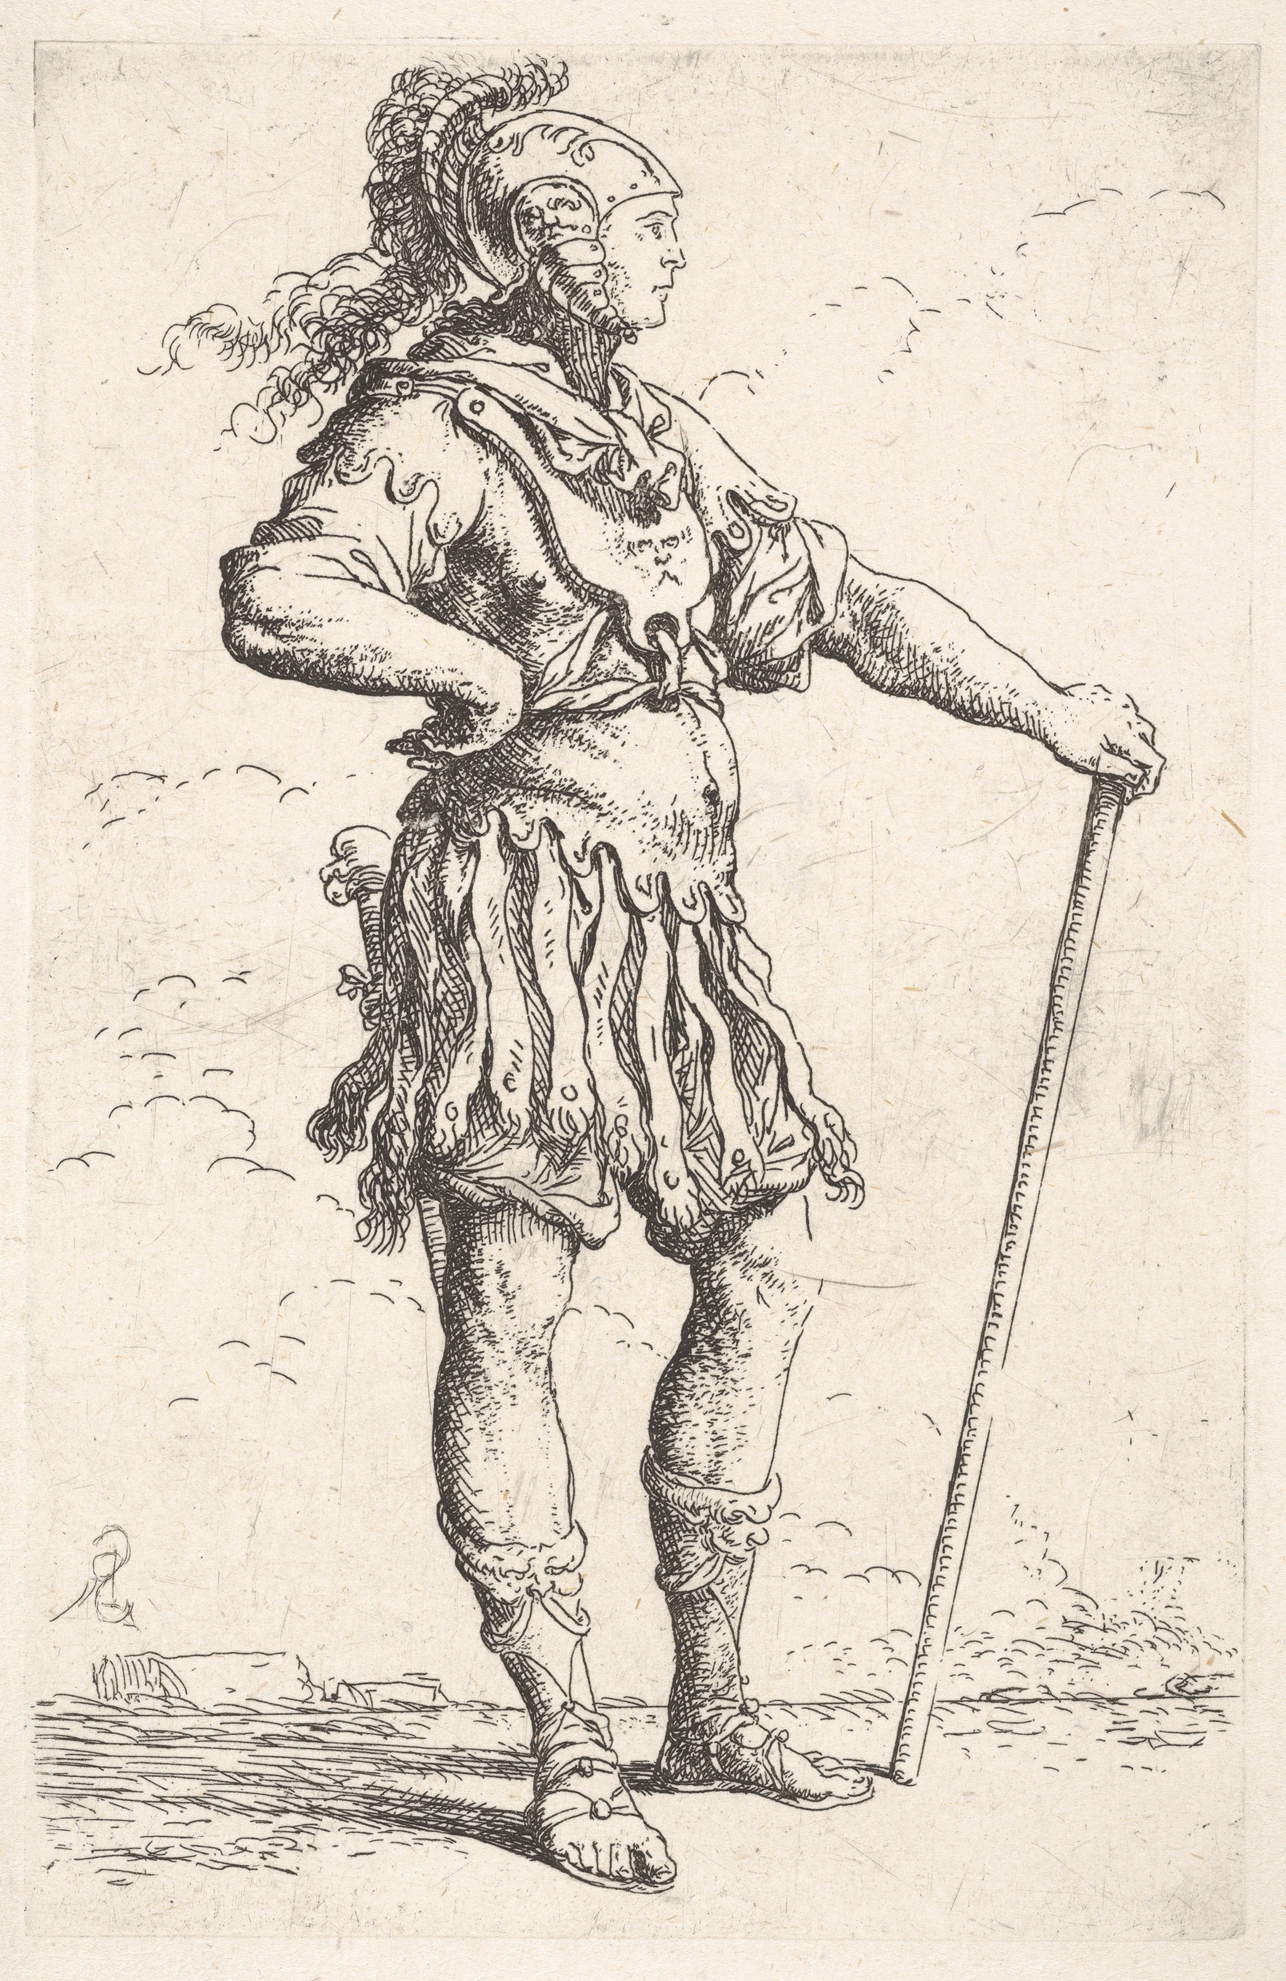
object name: print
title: A warrior facing right wearing a plumed helmet and holding a staff, from "Figurine"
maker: salvator rosa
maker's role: artist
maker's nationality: italian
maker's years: 1615-1673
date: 1656-1657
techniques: drypoint, etching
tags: soldiers,men